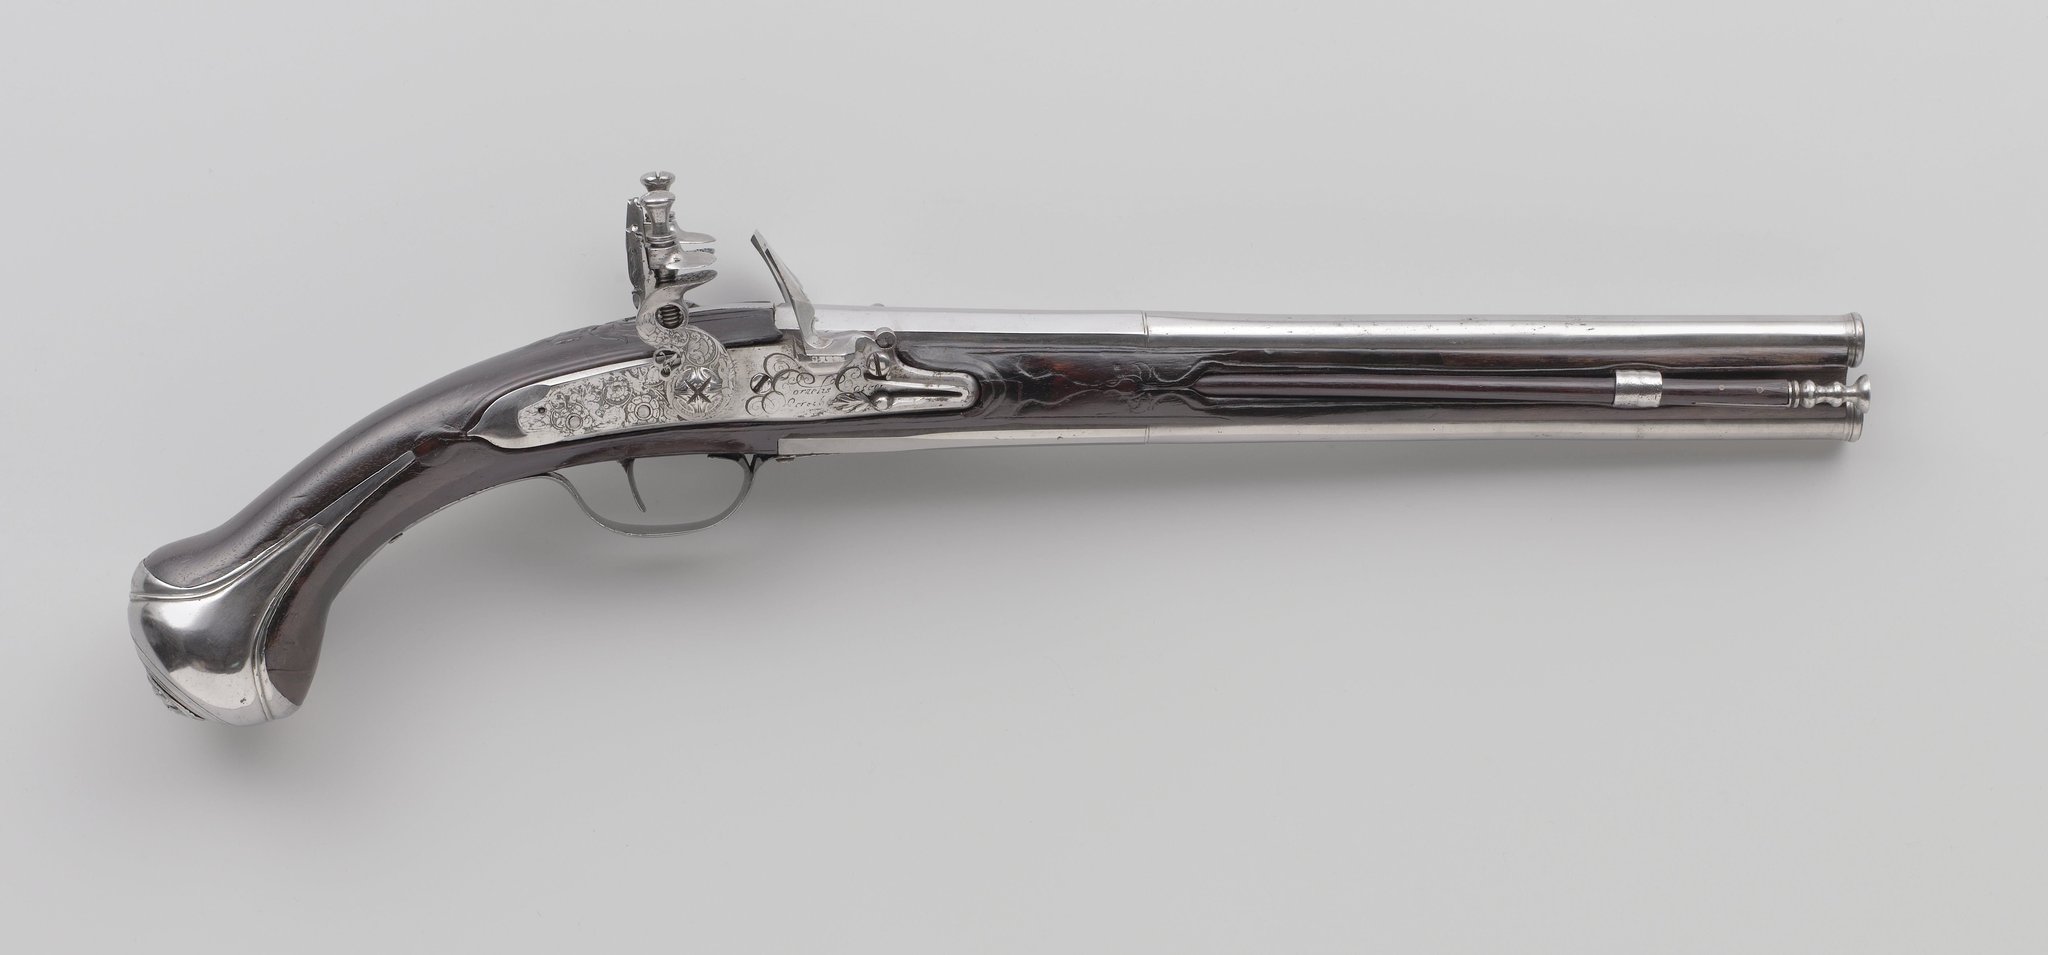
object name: flintlock pistol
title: Dubbelloops vuursteenpistool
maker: cornelis coster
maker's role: geweermaker, pistoolmaker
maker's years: -1698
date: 1660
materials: iron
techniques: printing, cutting, engraving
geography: utrecht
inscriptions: signature: ‘Cornelis Coster // Vtrecht’, : ‘C’, : ‘C’